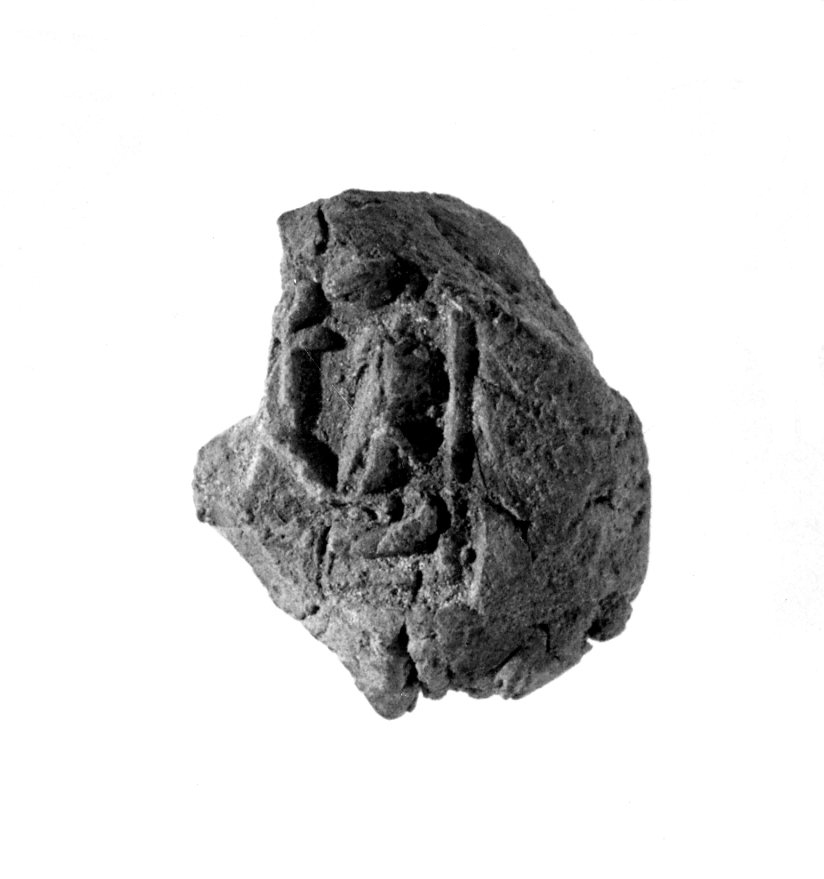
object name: sealing, nebmaatre, amenhotep iii,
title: Document Sealing with the Throne Name of Amenhotep III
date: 1390-1352 BCE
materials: mud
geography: egypt